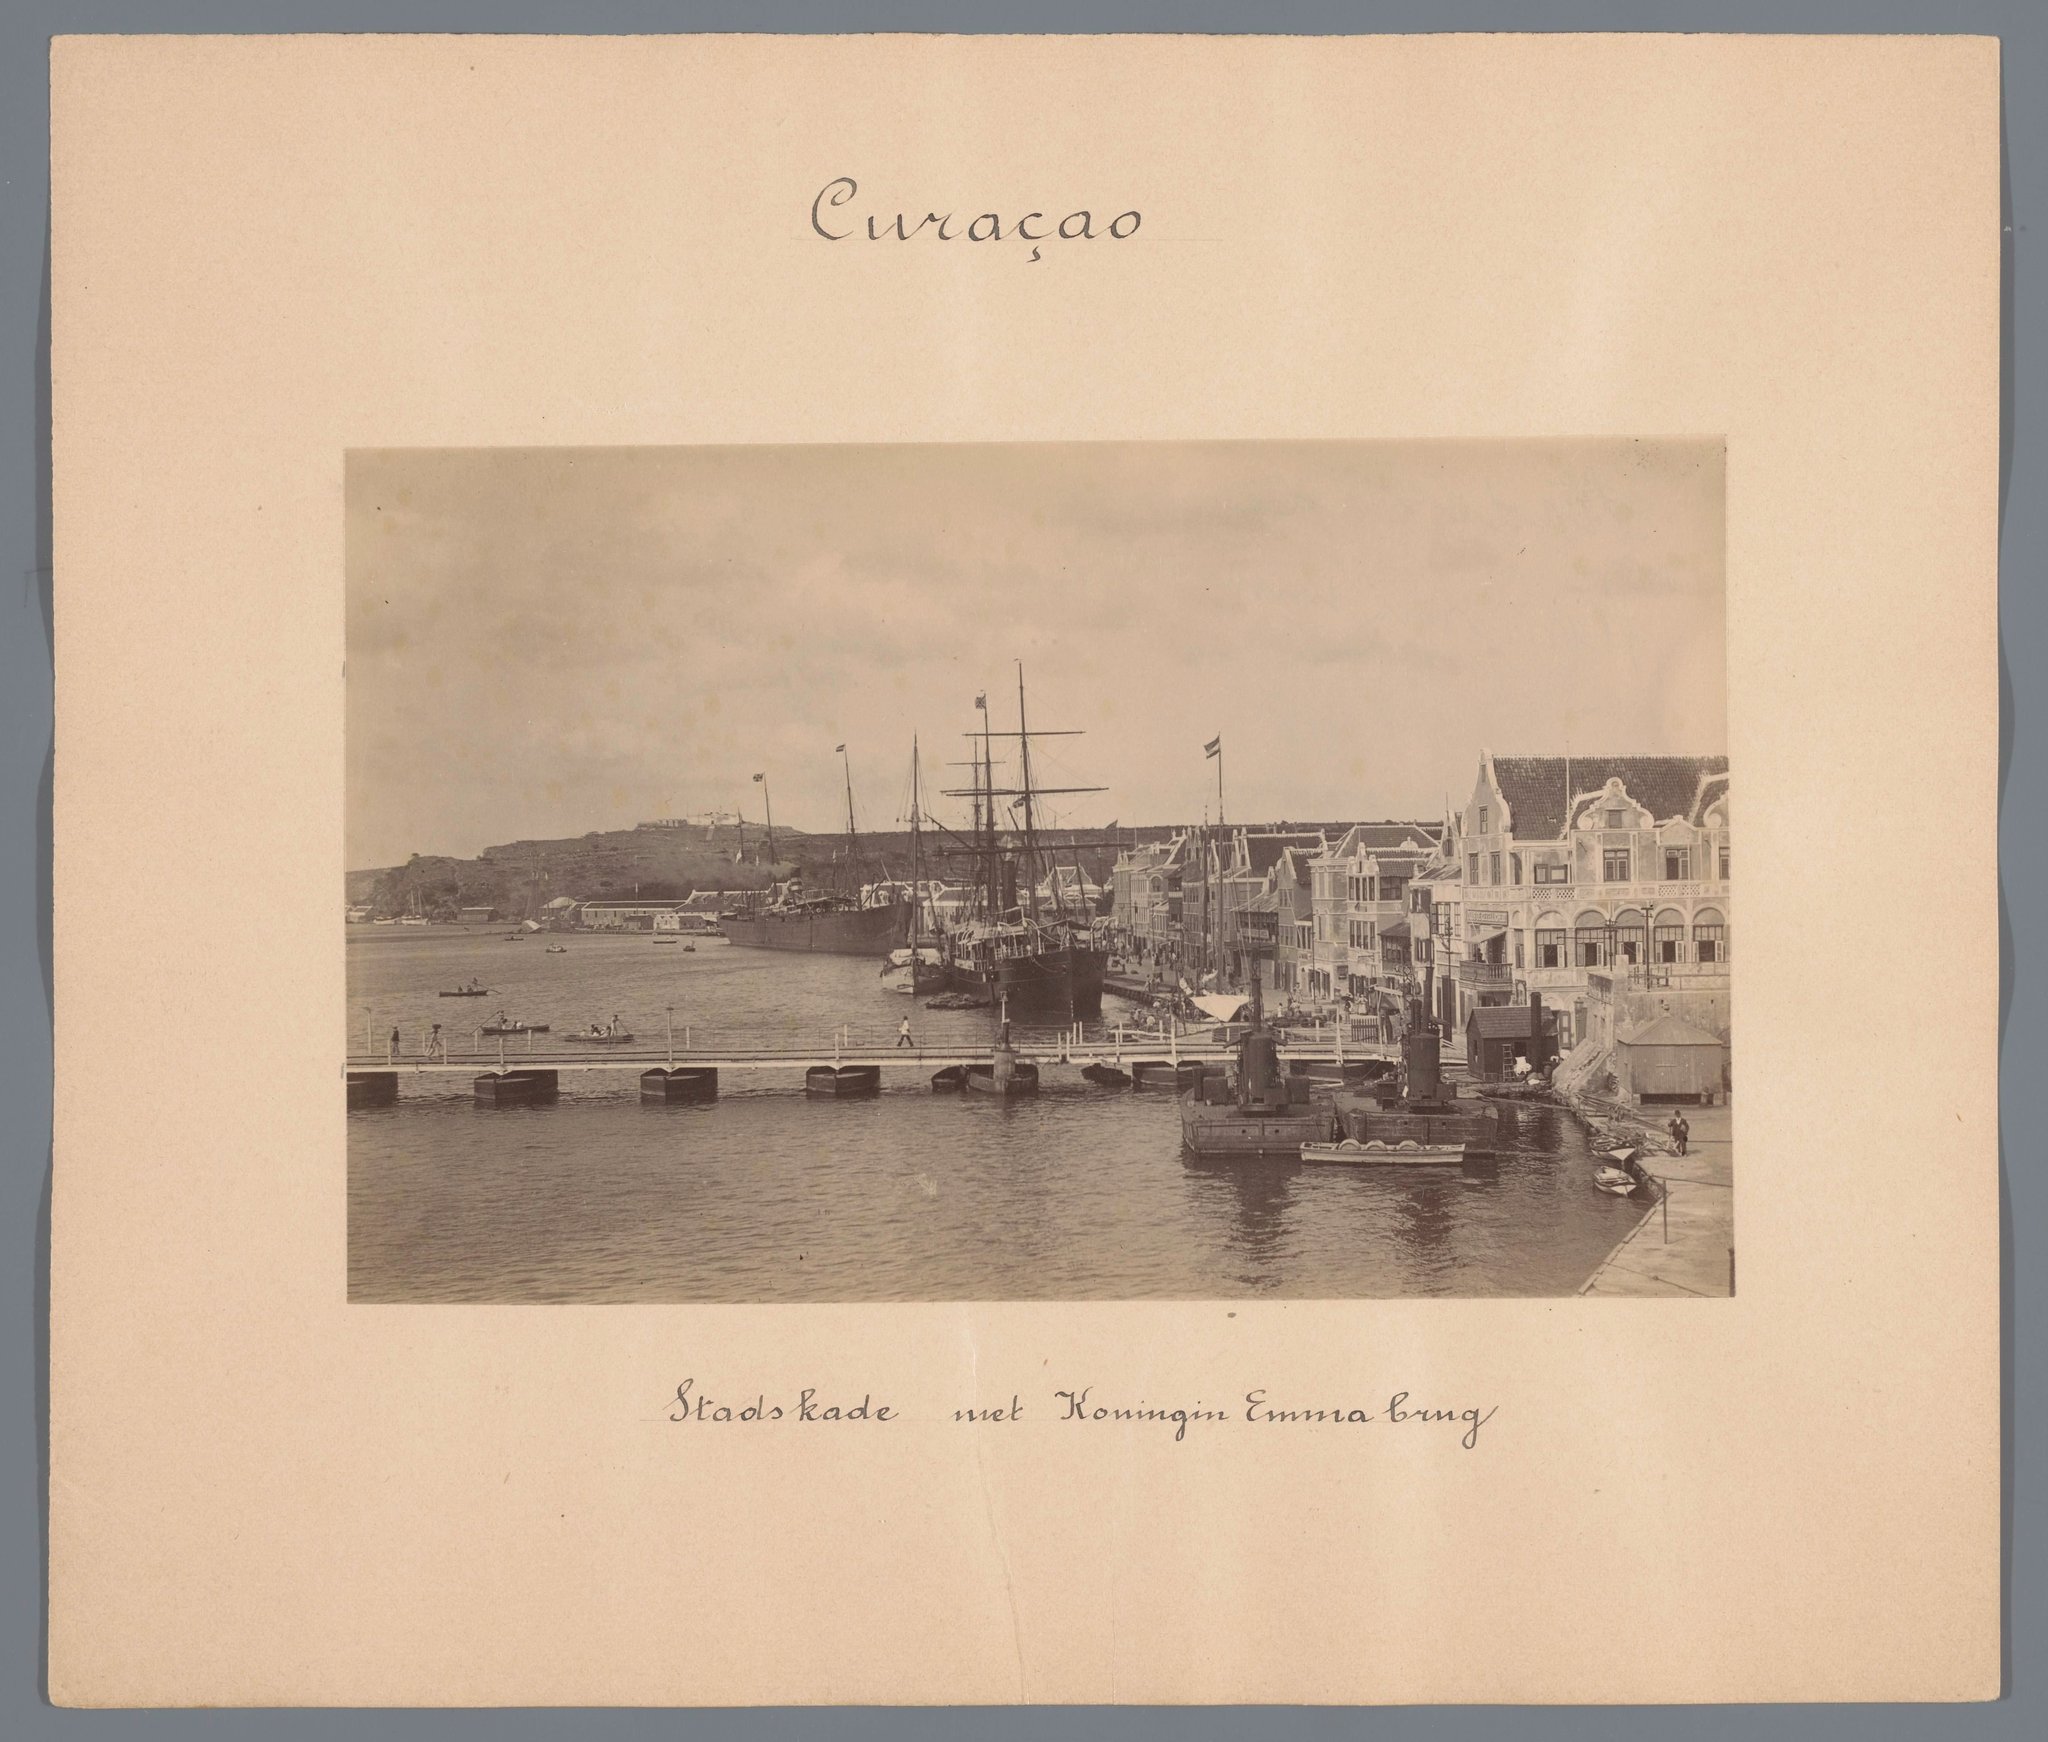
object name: photograph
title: Curaçao / Stadskade met Koningin Emma brug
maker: Anonymous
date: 1900-1905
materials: cardboard, photographic support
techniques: gelatin silver print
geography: willemstad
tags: willemstad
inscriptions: inscription: ‘Curaçao / Stadskade met Koningin Emma brug’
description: Gezicht op de kade van Willemstad op Curaçao, met de Koningin Emmabrug. Onderdeel van een groep van 44 foto's van Paramaribo, Suriname en Curaçao, ca. 1900-1905, opgeplakt op kartons en voorzien van opschriften.